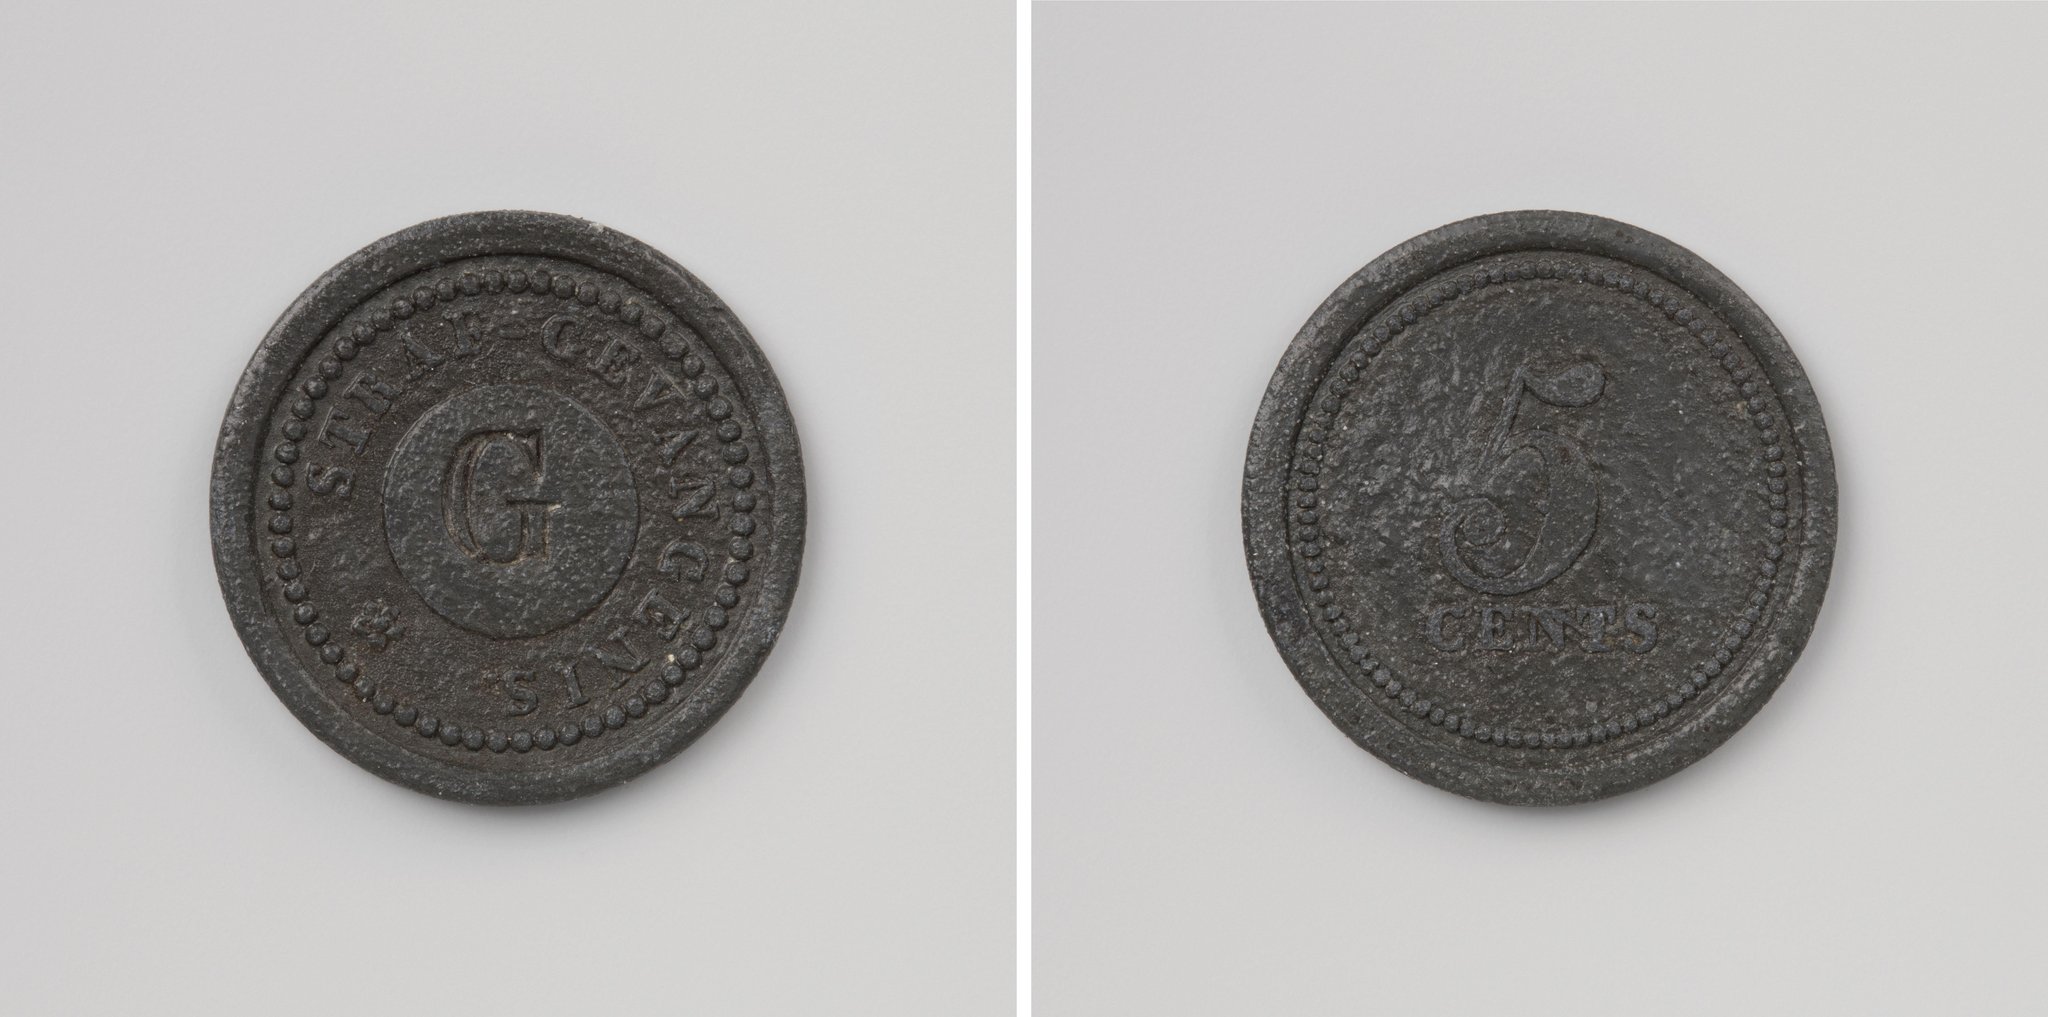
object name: monetary token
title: Strafgevangenis te Gouda, huismunt ter waarde van vijf cent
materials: zinc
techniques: striking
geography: utrecht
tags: gouda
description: Zinken betaalpenning. Voorzijde: letter G binnen omschrift. Keerzijde: waardeaanduiding.